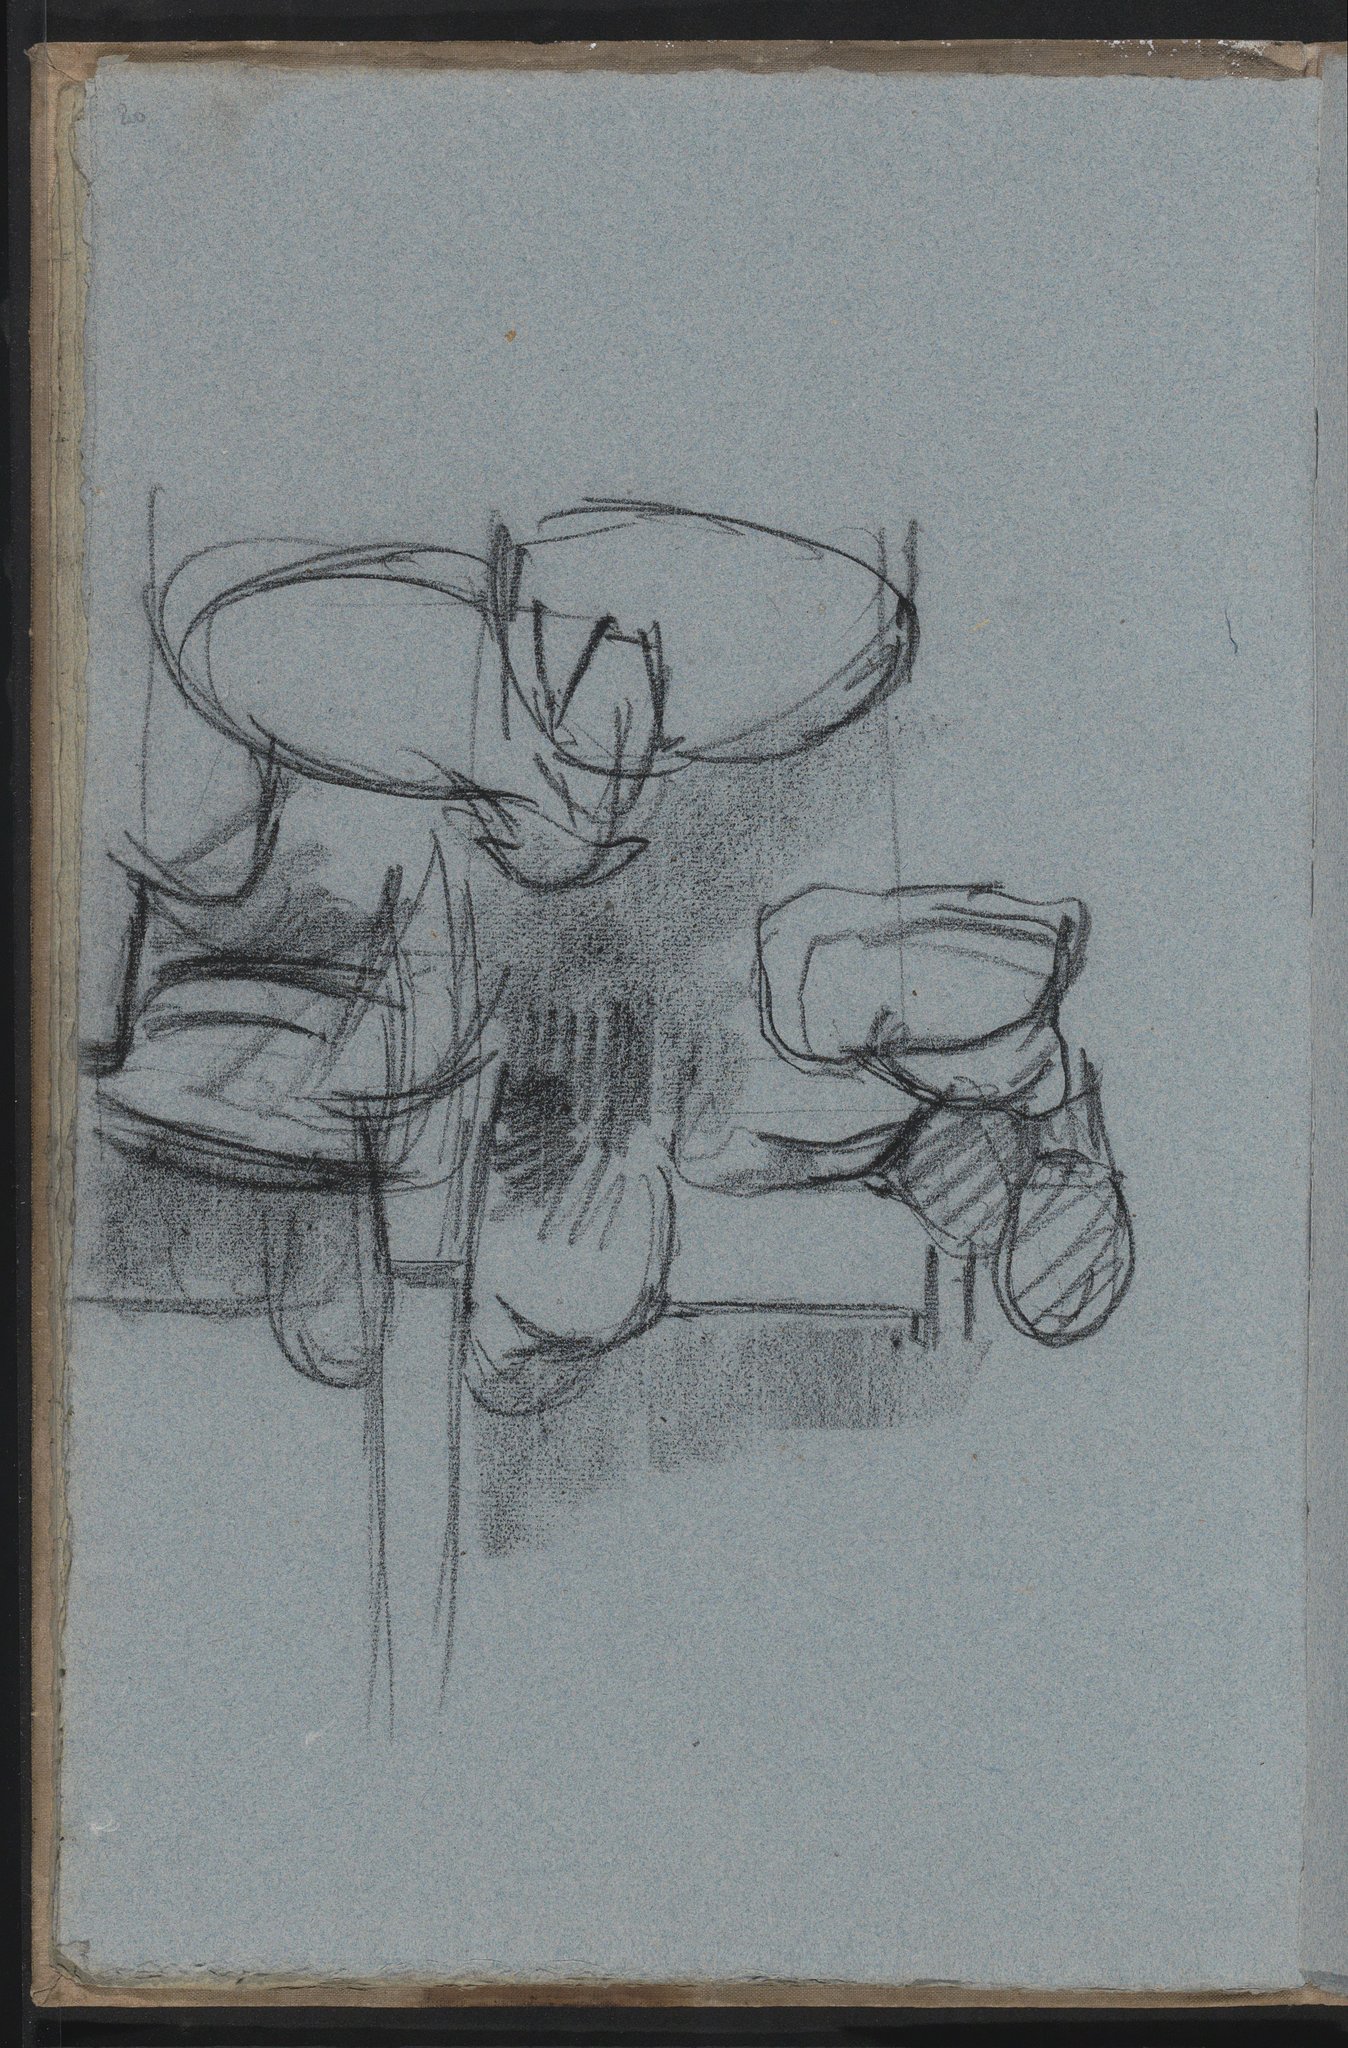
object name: sketchbook leaf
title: Liggende schapen in een schaapskooi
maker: willem witsen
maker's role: draughtsman, painter, print maker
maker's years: 1860-1923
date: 1884-1887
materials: chalk, paper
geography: ewijkshoeve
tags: sheep, stall, stable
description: Pagina 20 uit een schetsboek met 45 bladen vervaardigd rond de Ewijkshoeve.